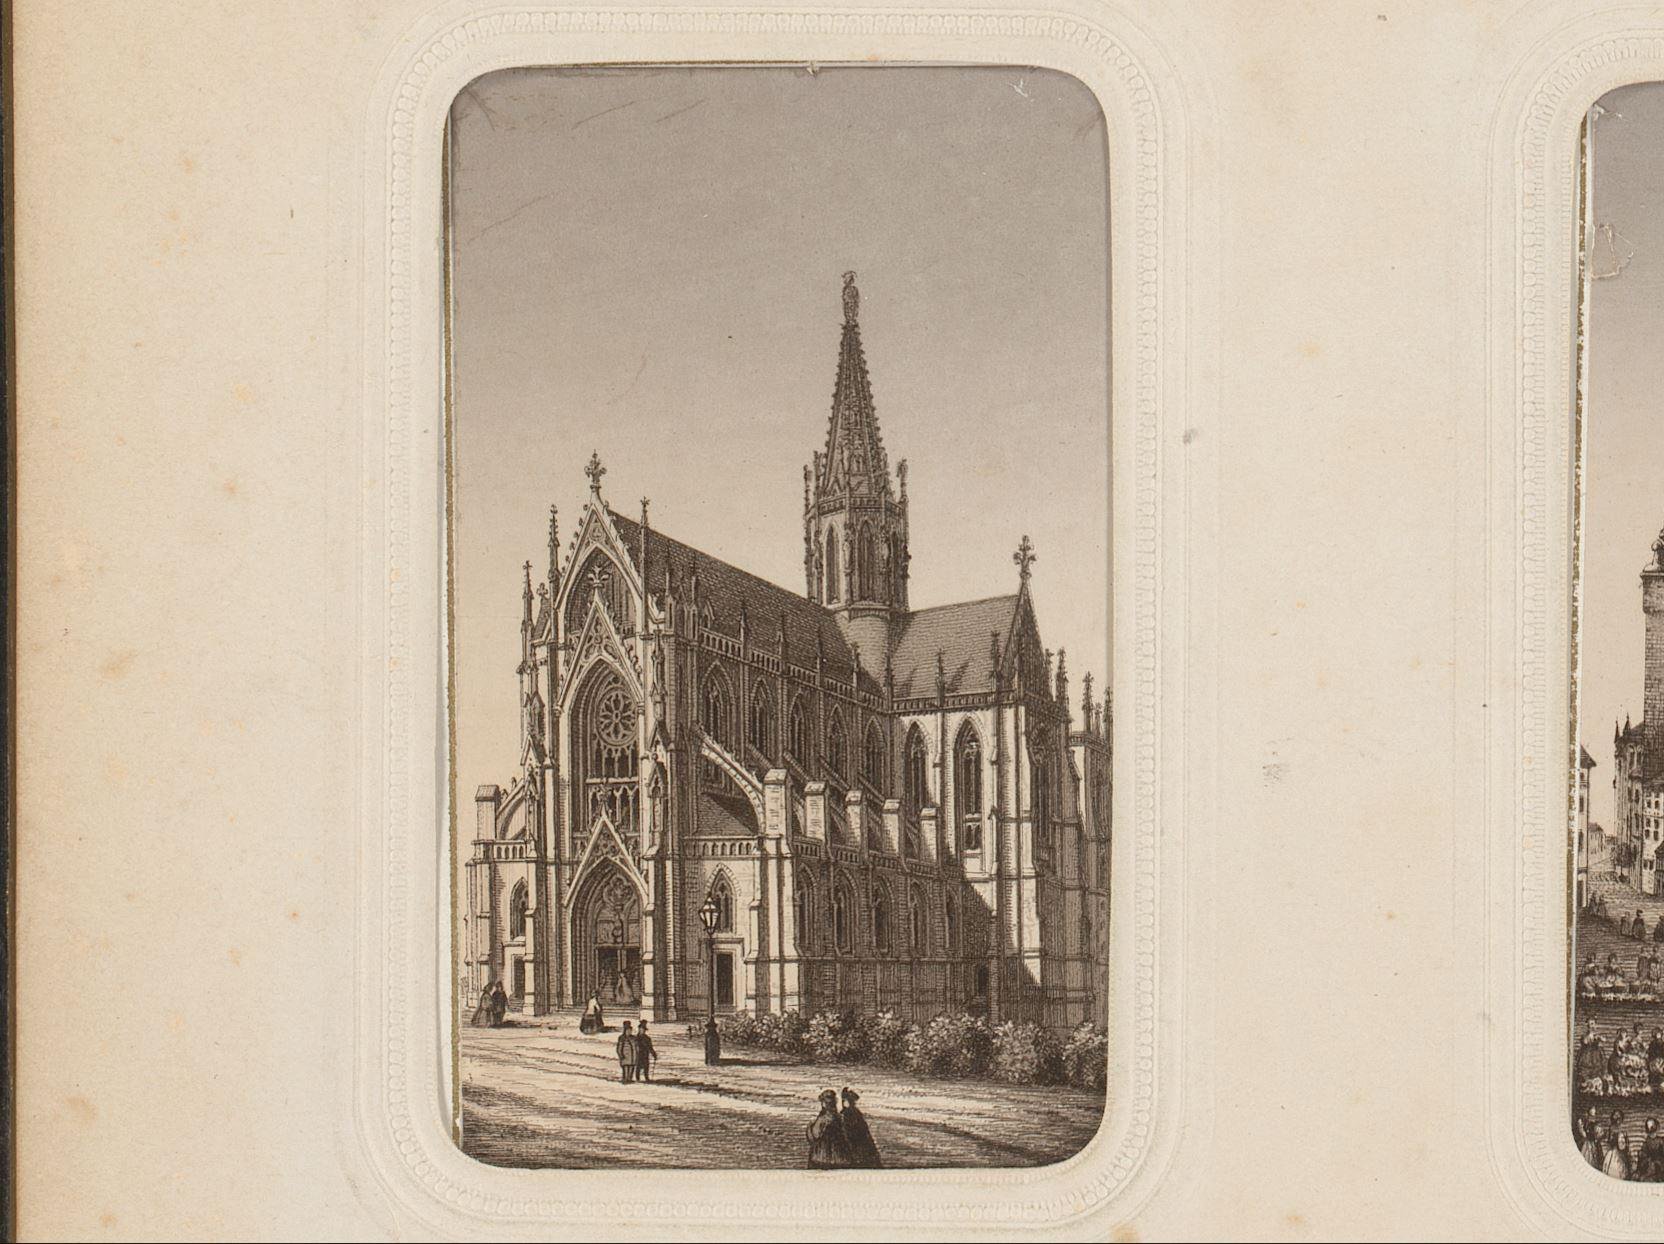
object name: reproduction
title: Aachen, Votivkirche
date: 1860-1885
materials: cardboard, photographic support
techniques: collodion silver print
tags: aken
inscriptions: annotation: ‘Aken/ Votivkirche’, annotation: ‘Aken/ Votivkirche’